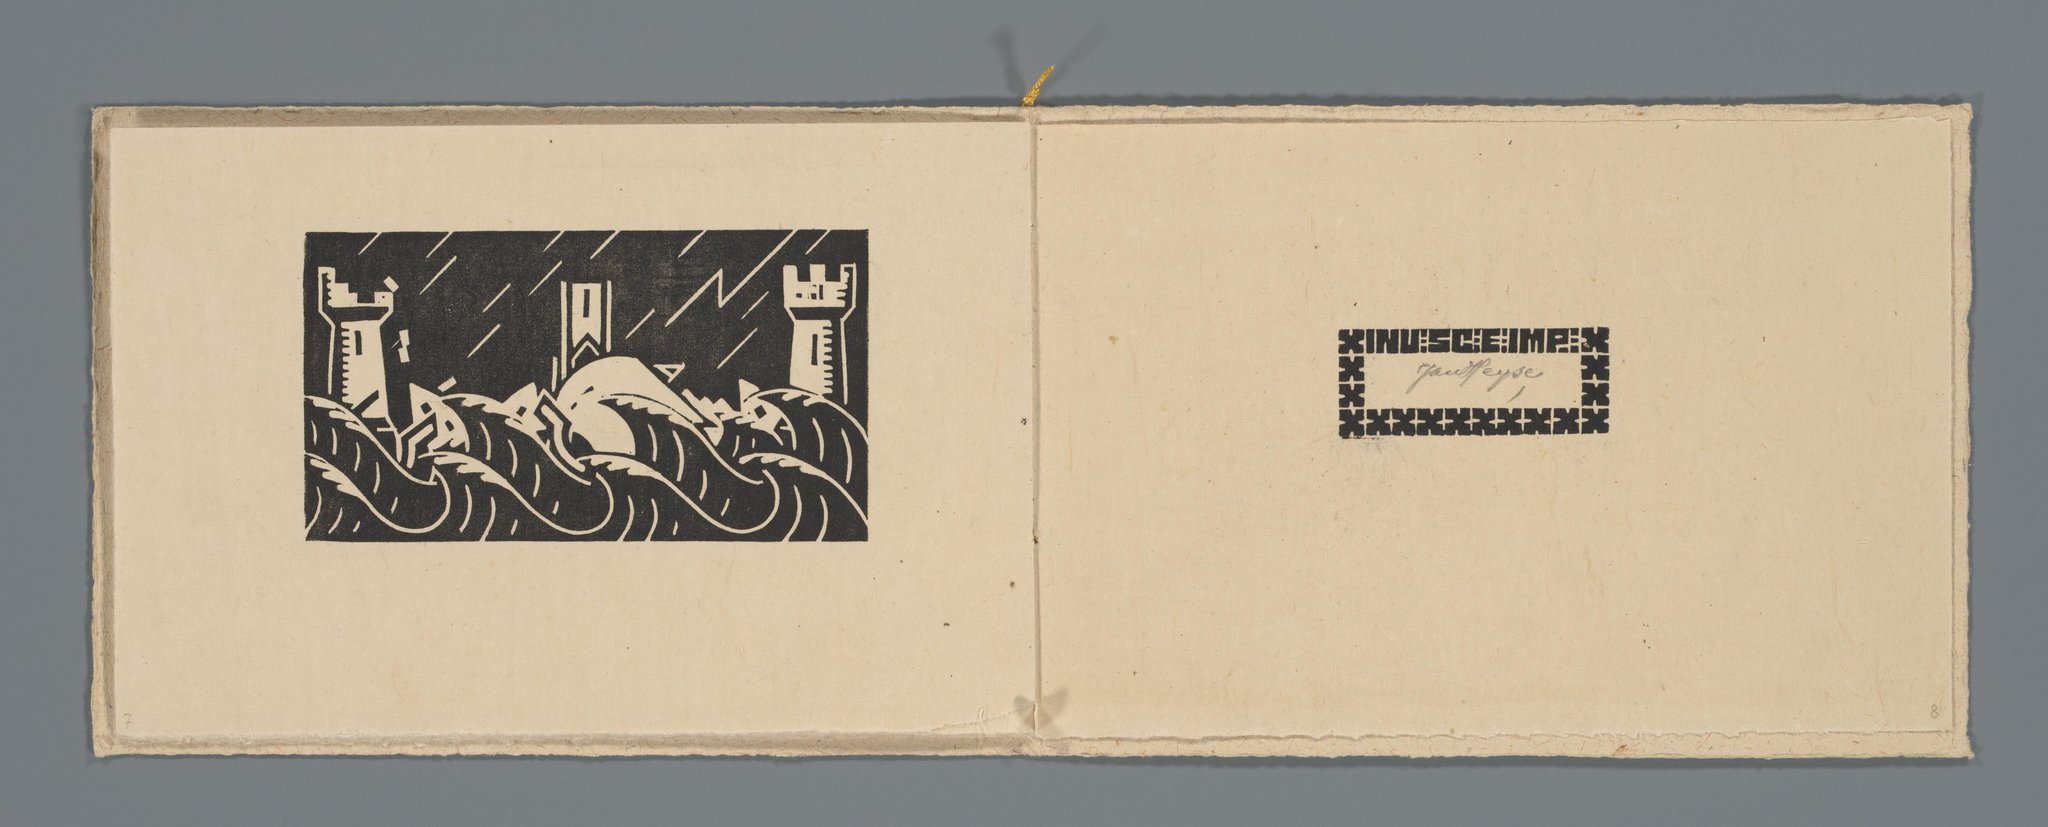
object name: print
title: Kader met kruismotief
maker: jan heyse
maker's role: painter, print maker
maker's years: 1882-1954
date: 1930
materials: paper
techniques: woodcut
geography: veere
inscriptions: date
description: Signatuur in het midden van het kader. Onderdeel van album 'Westenschouwe'.